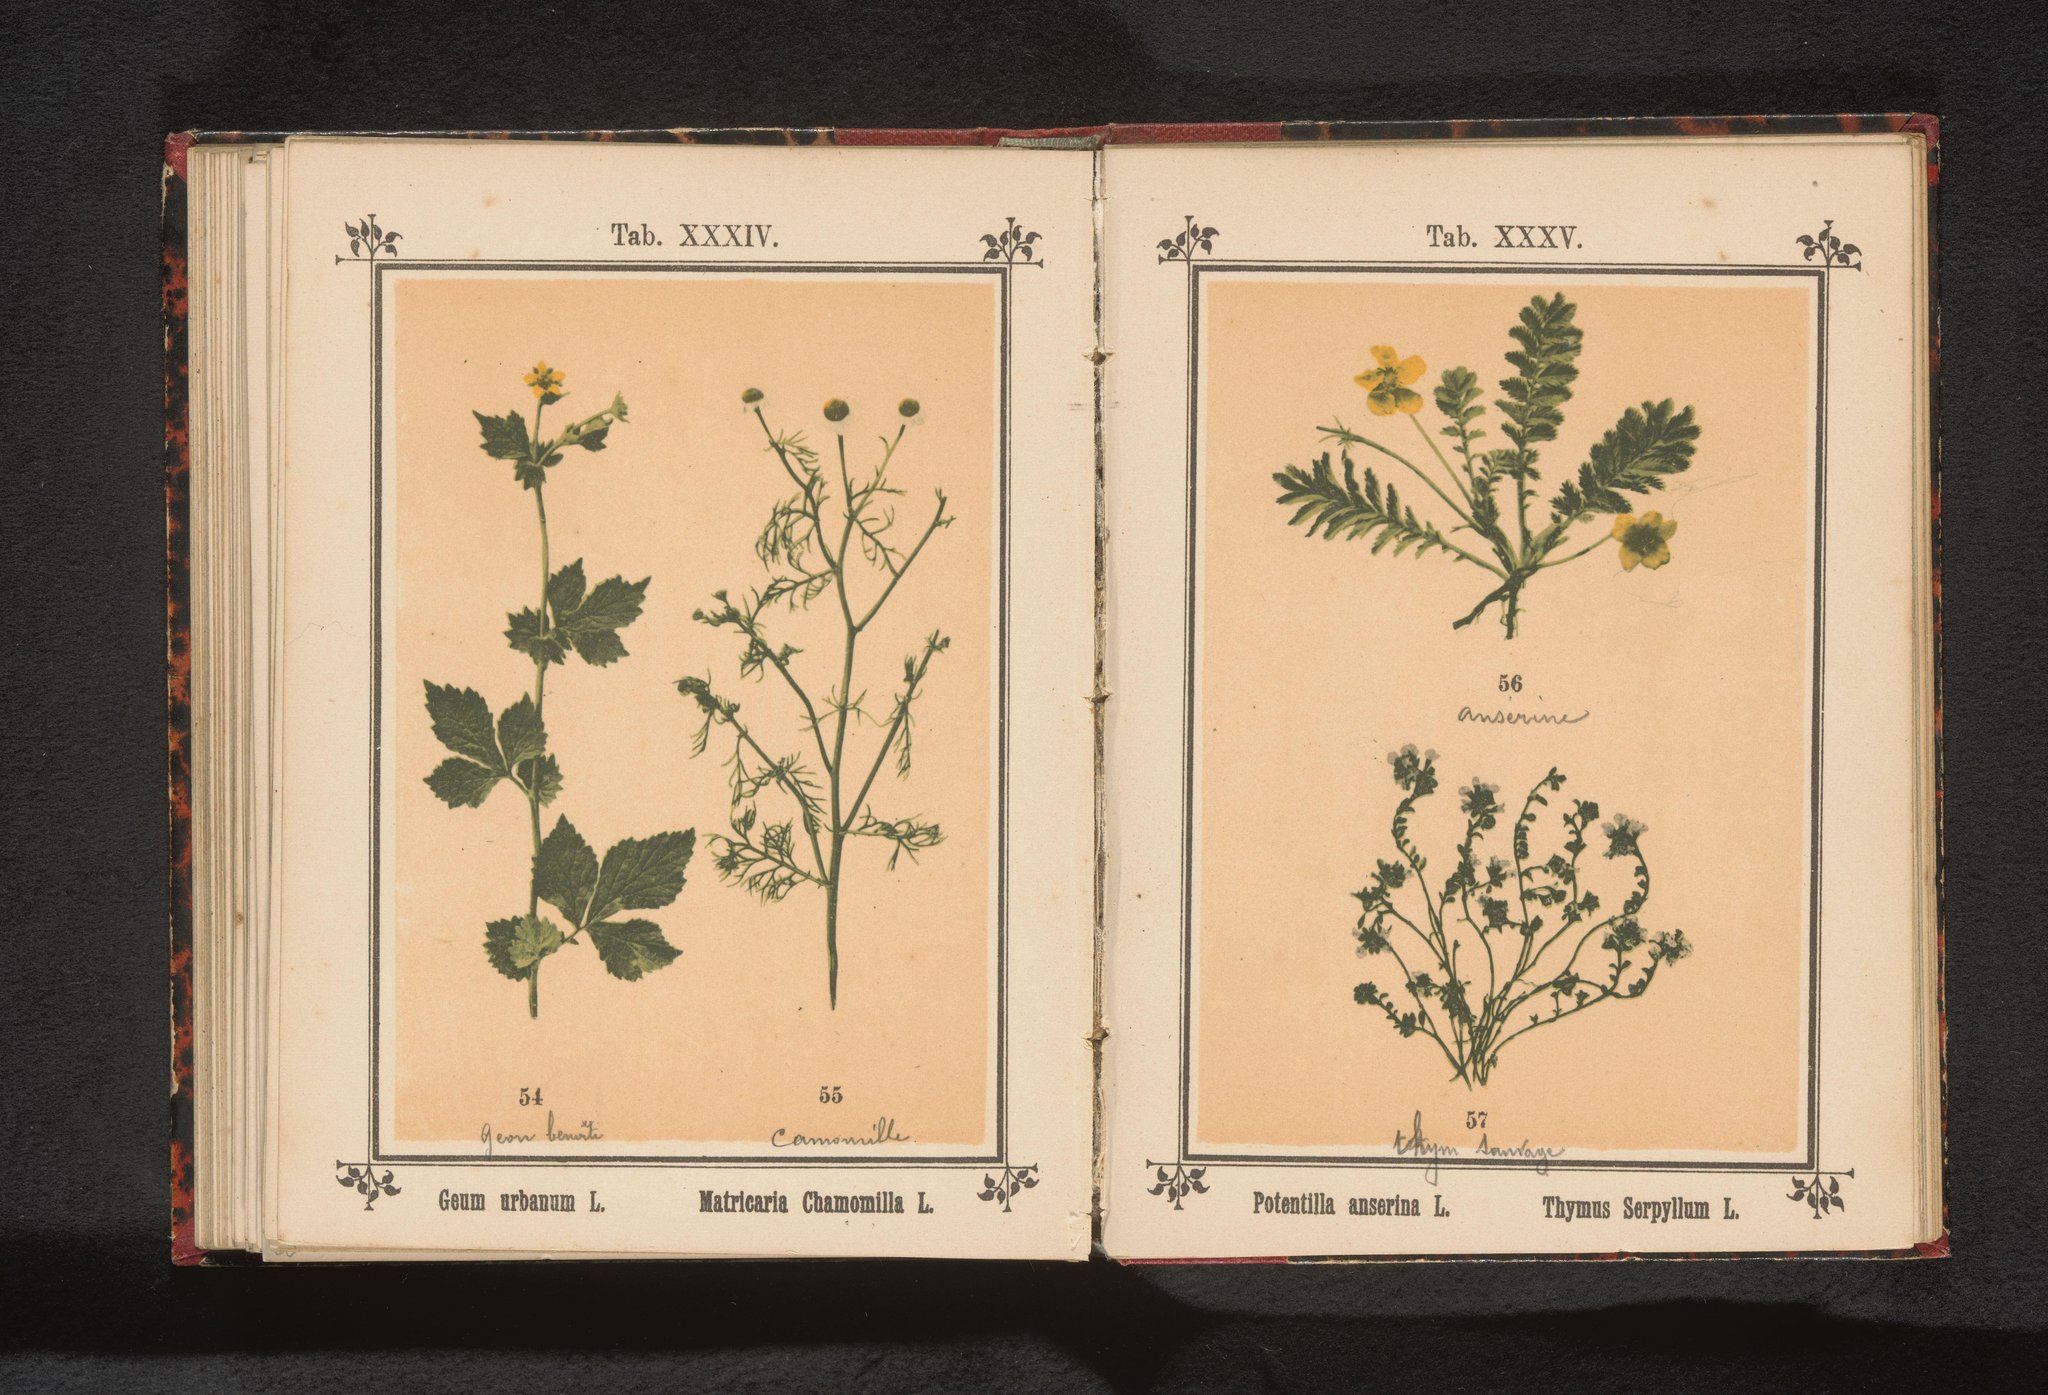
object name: photomechanical print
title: Potentilla anserina L. Thymus Serpyllum L.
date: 1884-1894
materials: paper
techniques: photograph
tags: plants (in general), plants and herbs: thyme (+ sprig, twig)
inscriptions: number: ‘Tab. XXXV.’, inscription: ‘anserine thym sauvage’